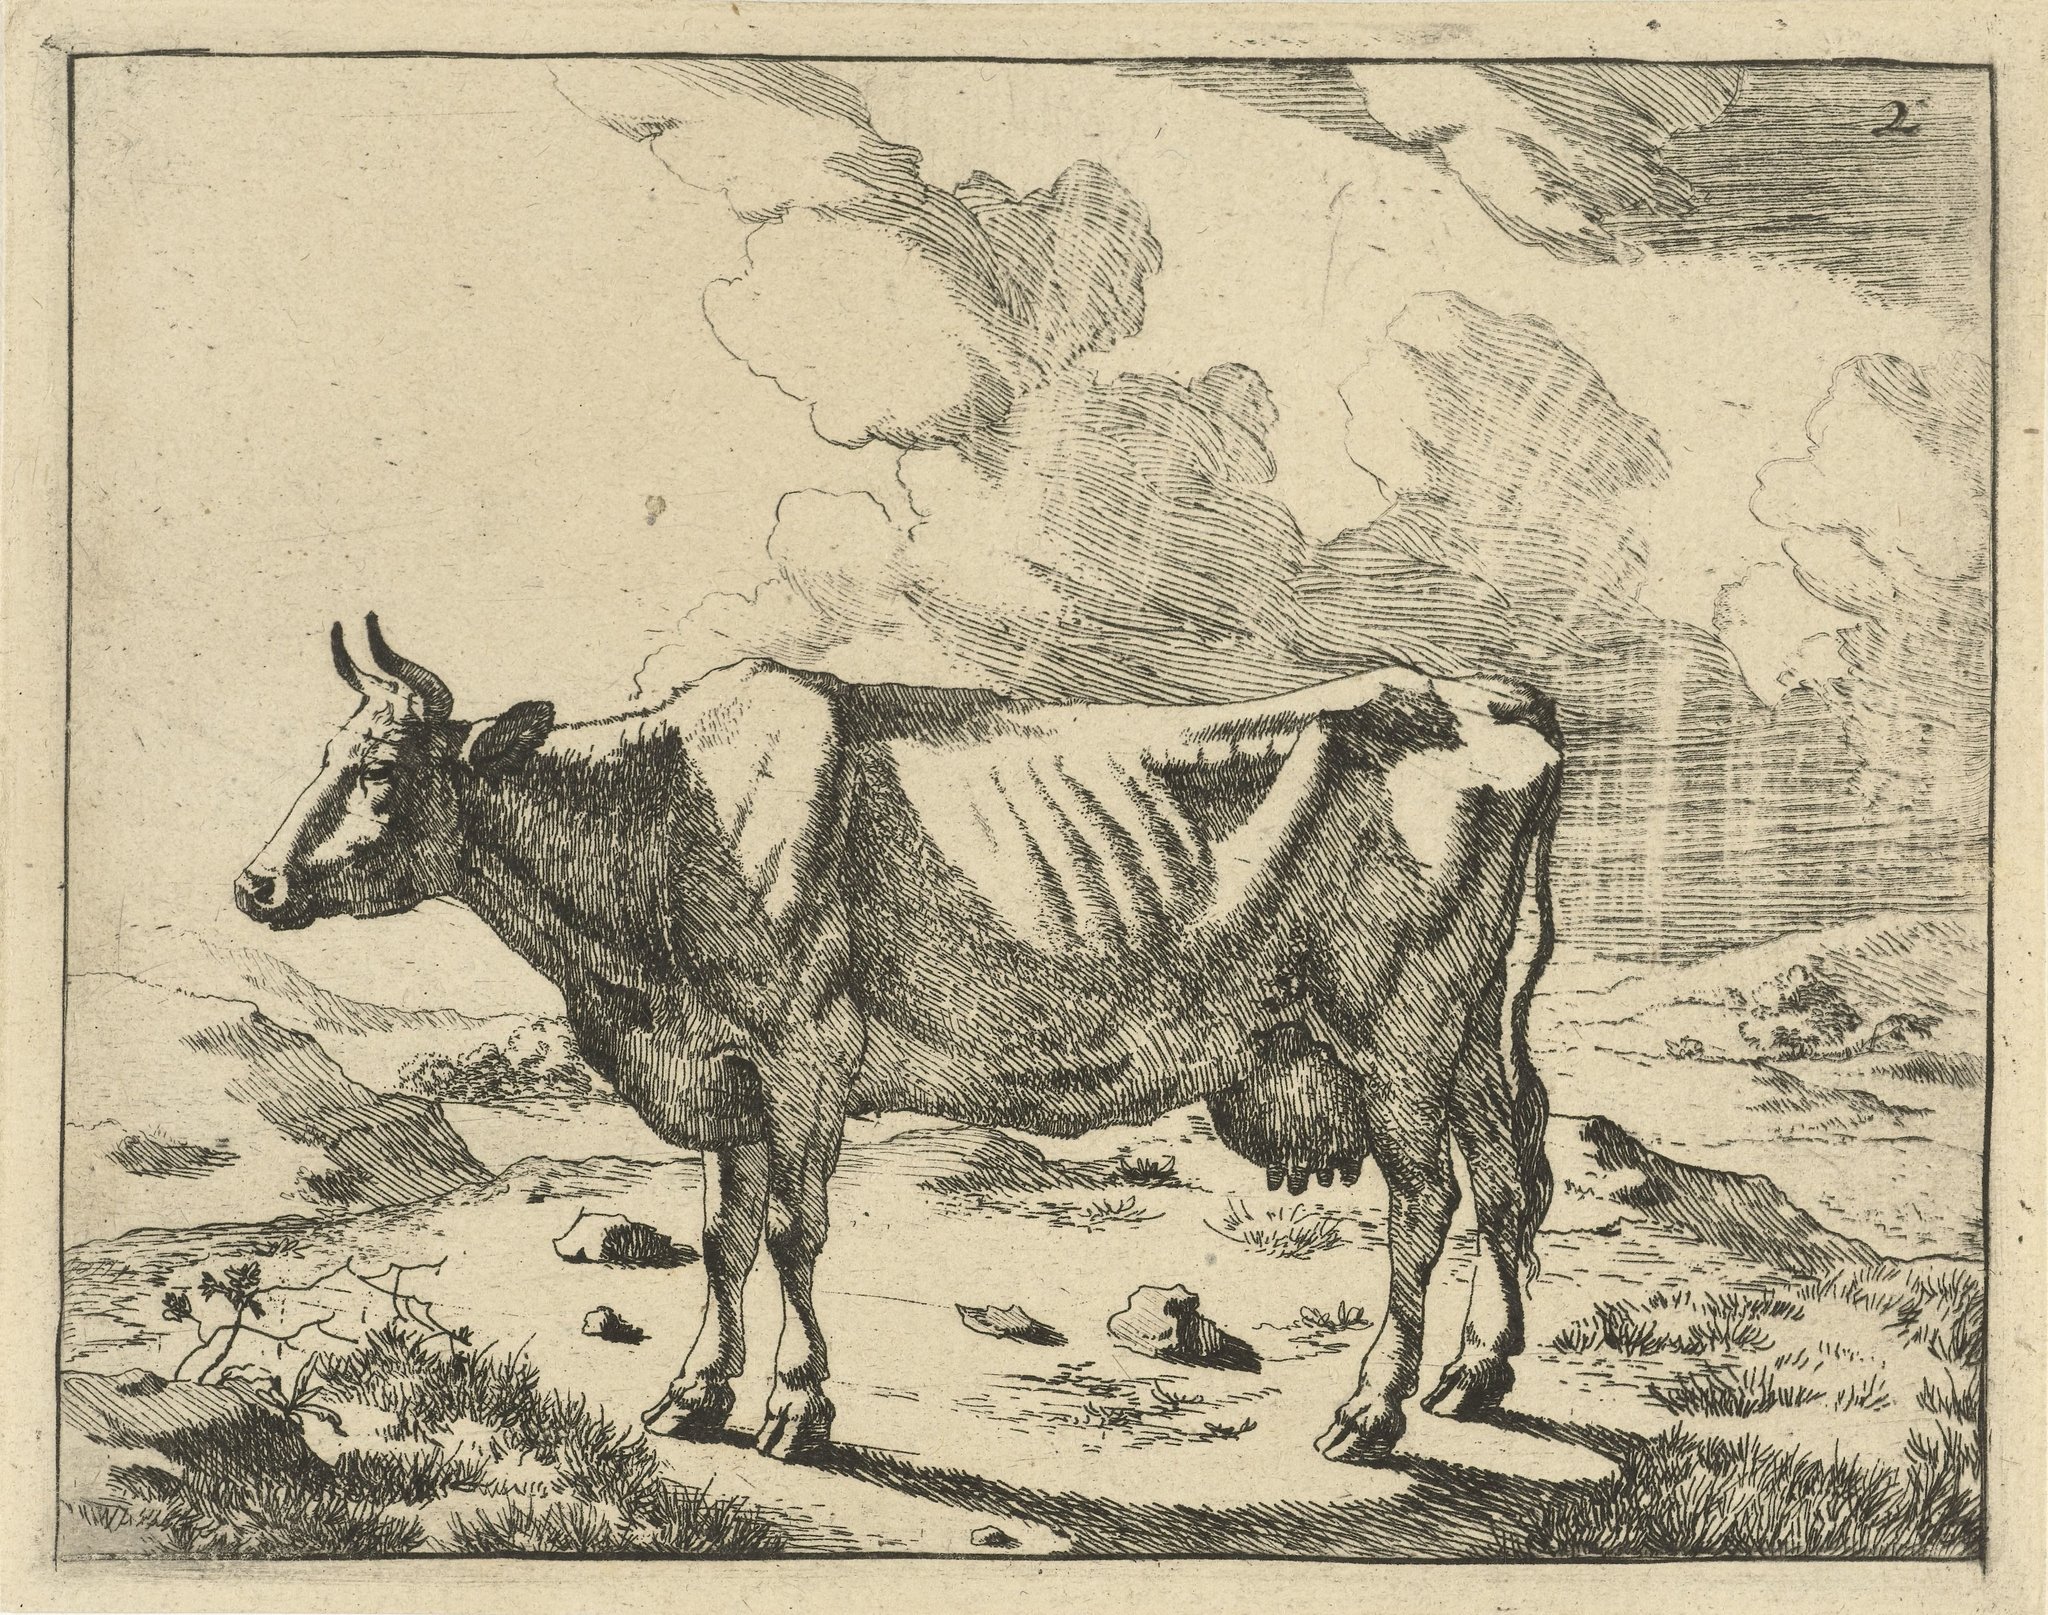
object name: print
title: Staande koe bij wolkenlucht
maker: marcus de bye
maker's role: print maker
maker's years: 1639-1688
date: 1657-1677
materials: paper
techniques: etching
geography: the hague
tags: cow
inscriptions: collector's mark: Lugt 2228